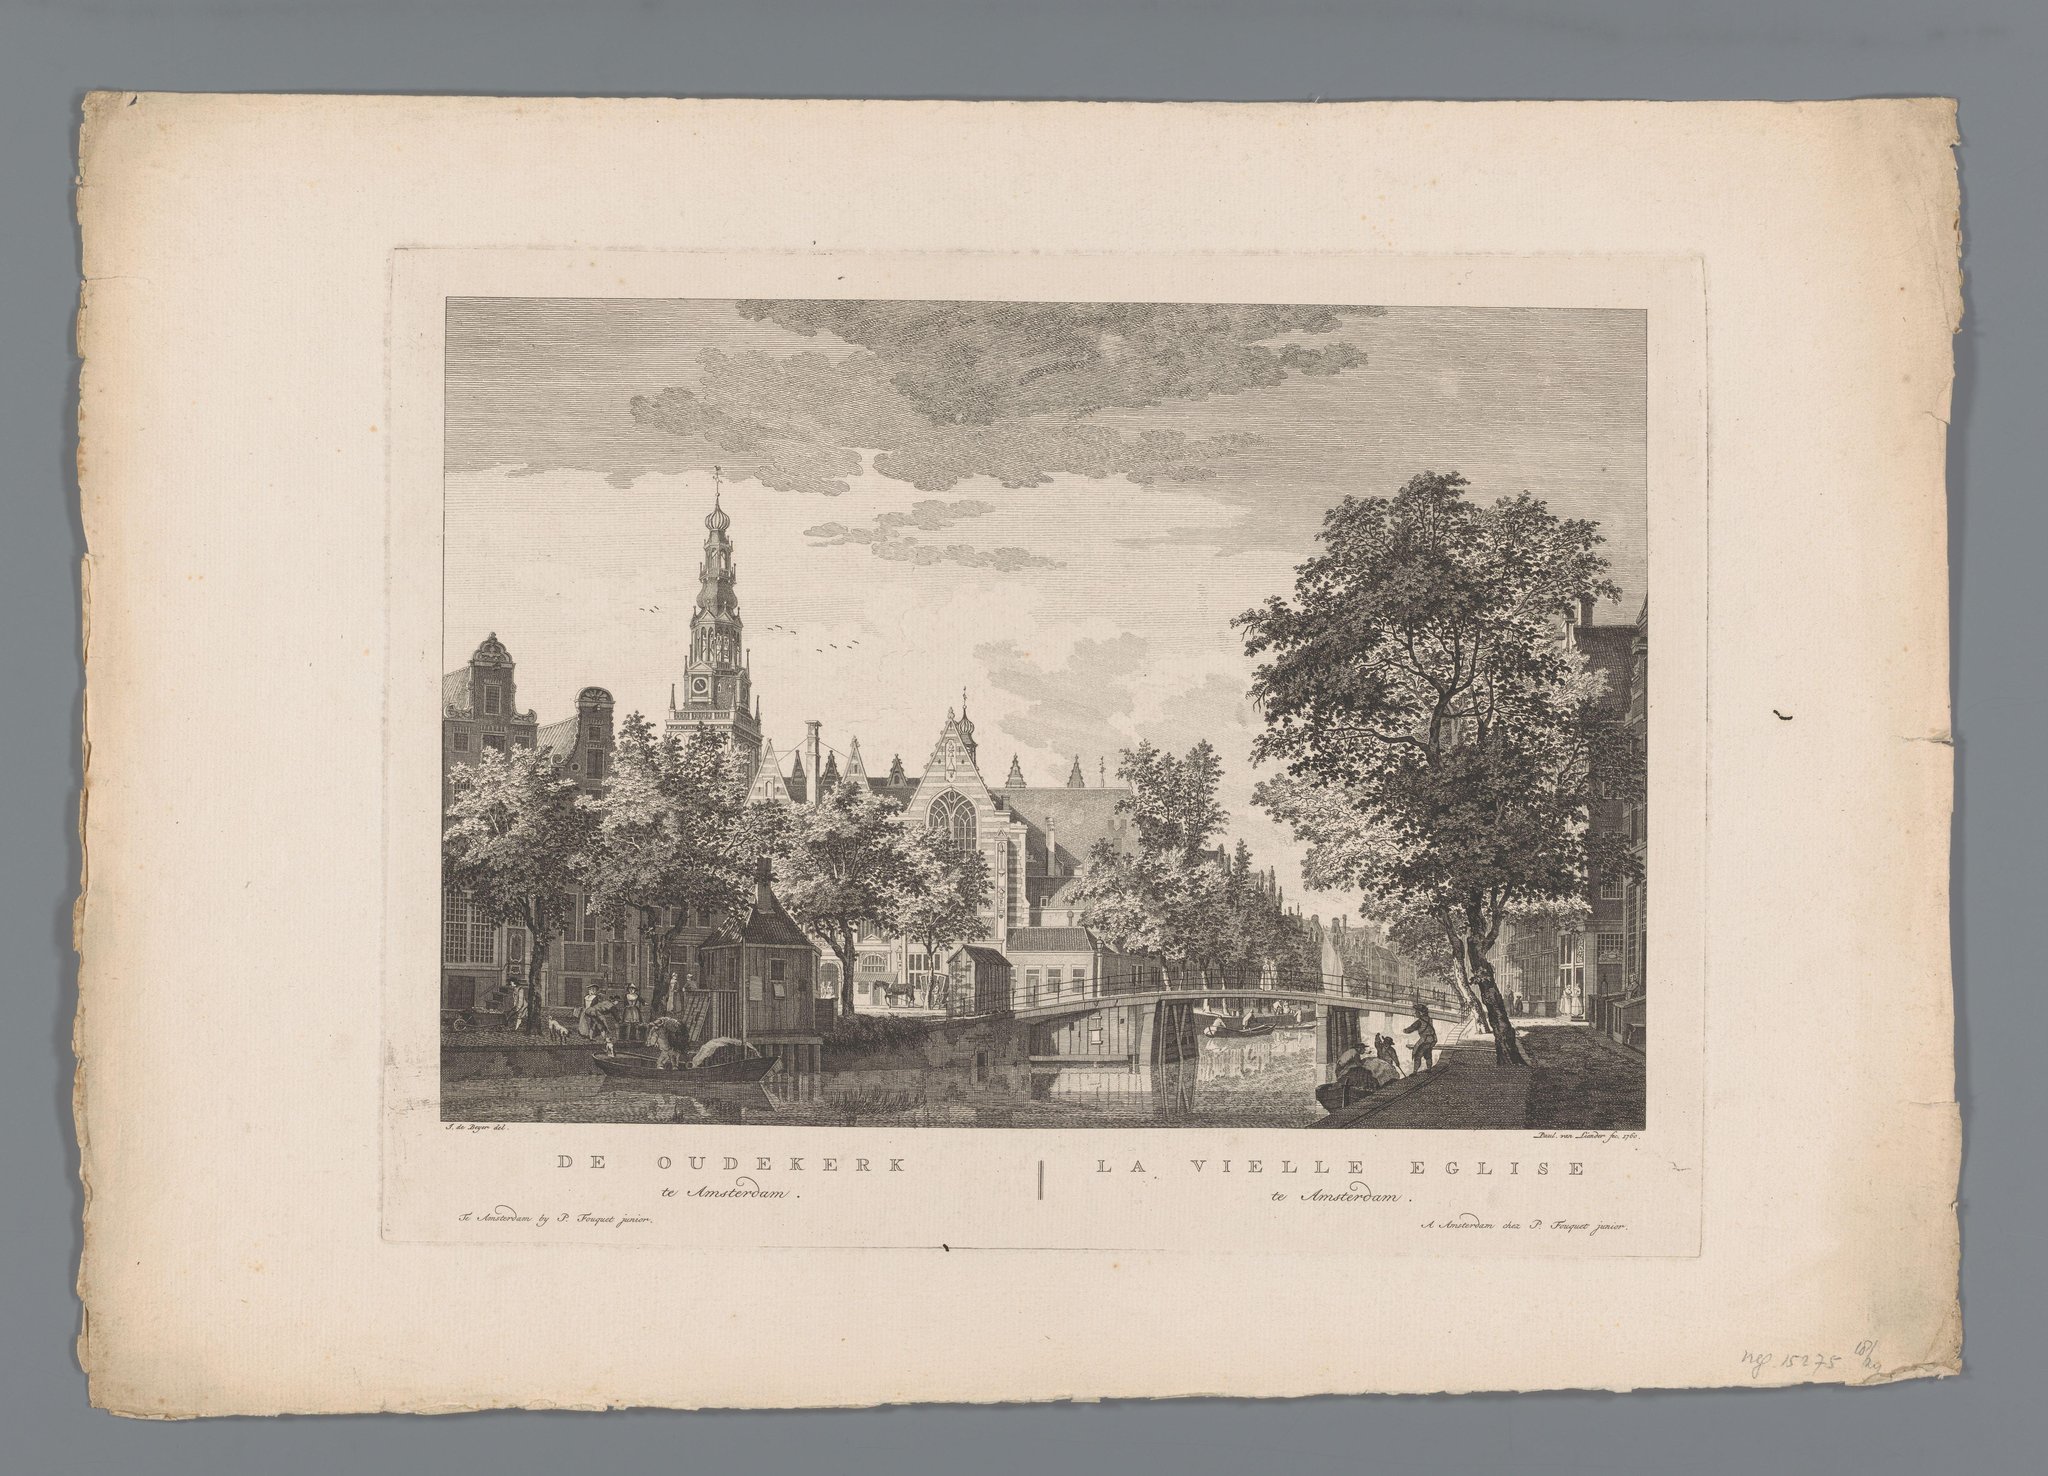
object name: book illustration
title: De Oudekerk te Amsterdam / La Viellle Eglise te Amsterdam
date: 1760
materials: paper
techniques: etching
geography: amsterdam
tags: church (exterior), canals, waters (in city) (+ city(-scape) with figures, staffage)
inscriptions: collector's mark: Lugt 2233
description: Deze prent is gebruikt in de zogenaamde Atlas van Fouquet. Pierre Fouquet gaf vanaf 1760 stadsgezichten van Amsterdam - naar tekeningen van verschillende kunstenaars, gemaakt door verschillende prentmakers - uit. Deze prenten werden aanvankelijk los of in series verkocht. Zoals toen gebruikelijk kon de koper de prenten zelf laten inbinden. Hiertoe gaf Fouquet tussen 1778 en 1783 een titelblad, plattegrond en inhoudsopgave van de tot dusver 100 uitgegeven prenten uit (1). Gezien de inhoud afhankelijk was van wat de koper had verzameld verschilt de inhoud van de verschillende bewaarde Fouquetatlassen onder deze titel sterk. Ook zijn er exemplaren bekend waar tevens andere prenten aan zijn toegevoegd. Omdat er behoefte bleek aan uitleg bij de platen werd in 1783 een nieuwe versie van de atlas uitgegeven, aangevuld met tekst en twee prenten. De aangegeven volgorde veranderde maar de platen van de al eerder uitgegeven prenten bleven ongewijzigd. Deze uitgave werd in opdracht van Fouquet gedrukt bij Daniël Jean Changuion en Petrus den Hengst (2). Een tiental platen werd bijgewerkt en verscheen, met nieuw impressum, in het vervolg van Wagenaars geschiedenis van Amsterdam, uitgeven door Petrus Conradi en Folkert van der Plaats (3). Een aantal jaar na het overlijden van Fouquet kwam Evert Maaskamp met een nieuwe uitgave van de atlas, met verbeterde tekst en toevoeging van twee prenten. Op alle platen verwijderde hij het oude en liet hij zijn eigen impressum zetten (4). (1). Afbeeldingen van de wyd-vermaarde koopstad Amsterdam benevens des zelvs voornaamste gebouwen en gezigten alle naar het leeven getekend / Receuil des edifices les plus considerables et des plus belles vues, de la fameuse ville d'Amsterdam, dessinées d'après nature. Amsterdam: Pierre Fouquet, 1778-1783. (2). Nieuwe atlas, van de voornaamste gebouwen en gezigten der stad Amsterdam, met derzelver beknopte beschryvingen. 2 dln. Amsterdam: Daniël Jean Changuion en Petrus den Hengst [in opdracht van Pierre Fouquet], 1783. (3). Stijl, Simon. Amsterdam, in zyne geschiedenissen, voorregten, koophandel, gebouwen, kerkenstaat, schoolen, schutterye, gilden en regeeringe, beschreeven. Om te dienen ten vervolge op het werk van Jan Wagenaar (…). 10 dln. Amsterdam en Harlingen: Petrus Conradi en Folkert van der Plaats, 1788-1801. (4). Nieuwe atlas, van de voornaamste gebouwen en gezigten der stad Amsterdam. Met derzelver beknopte beschryvingen. Amsterdam: Evert Maaskamp, 1805.